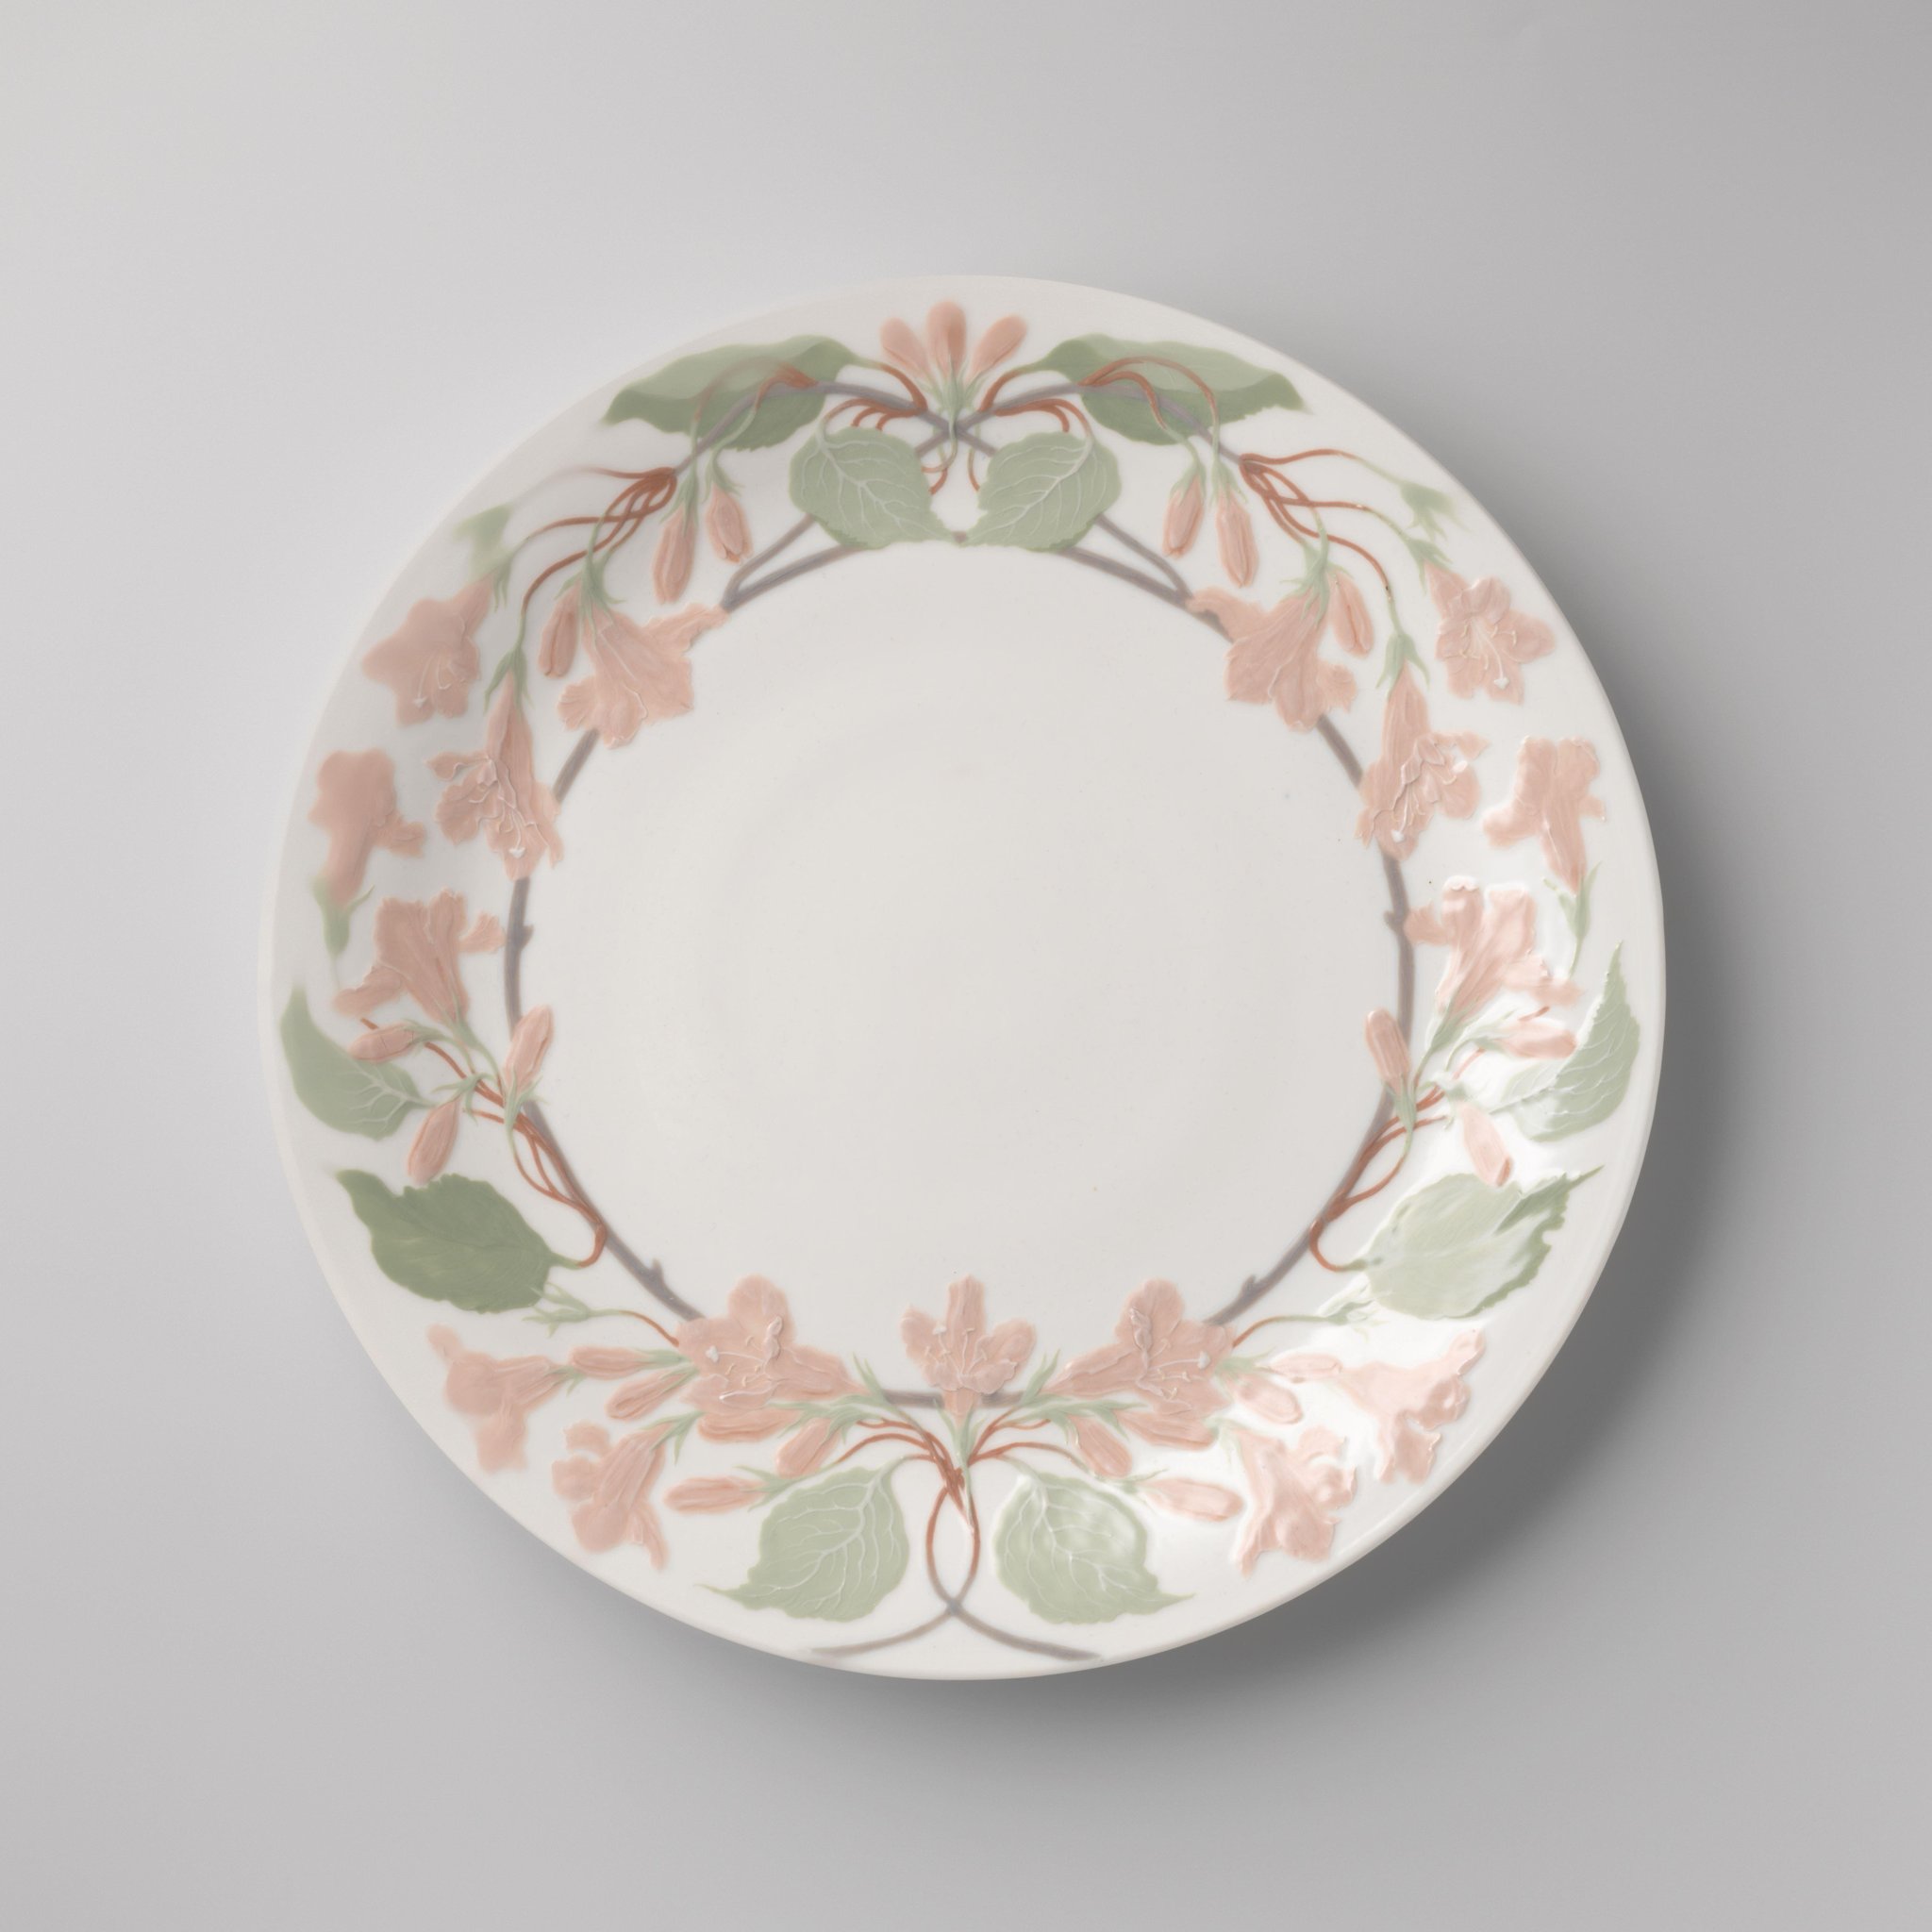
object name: platter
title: Schotel, veelkleurig beschilderd met kweepeerbloesems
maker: julius hentschel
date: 1895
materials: porcelain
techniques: pâte sur pâte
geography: meissen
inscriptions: factory mark: ‘gekruiste zwaarden’, model number: ‘F177’, check stamp: ‘13’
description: Dish. Porcelain. Meissen, Königlich Sächsische Porzellanmanufaktur, c. 1895, the design of the decoration attributed to Julius Konrad Hentschel.